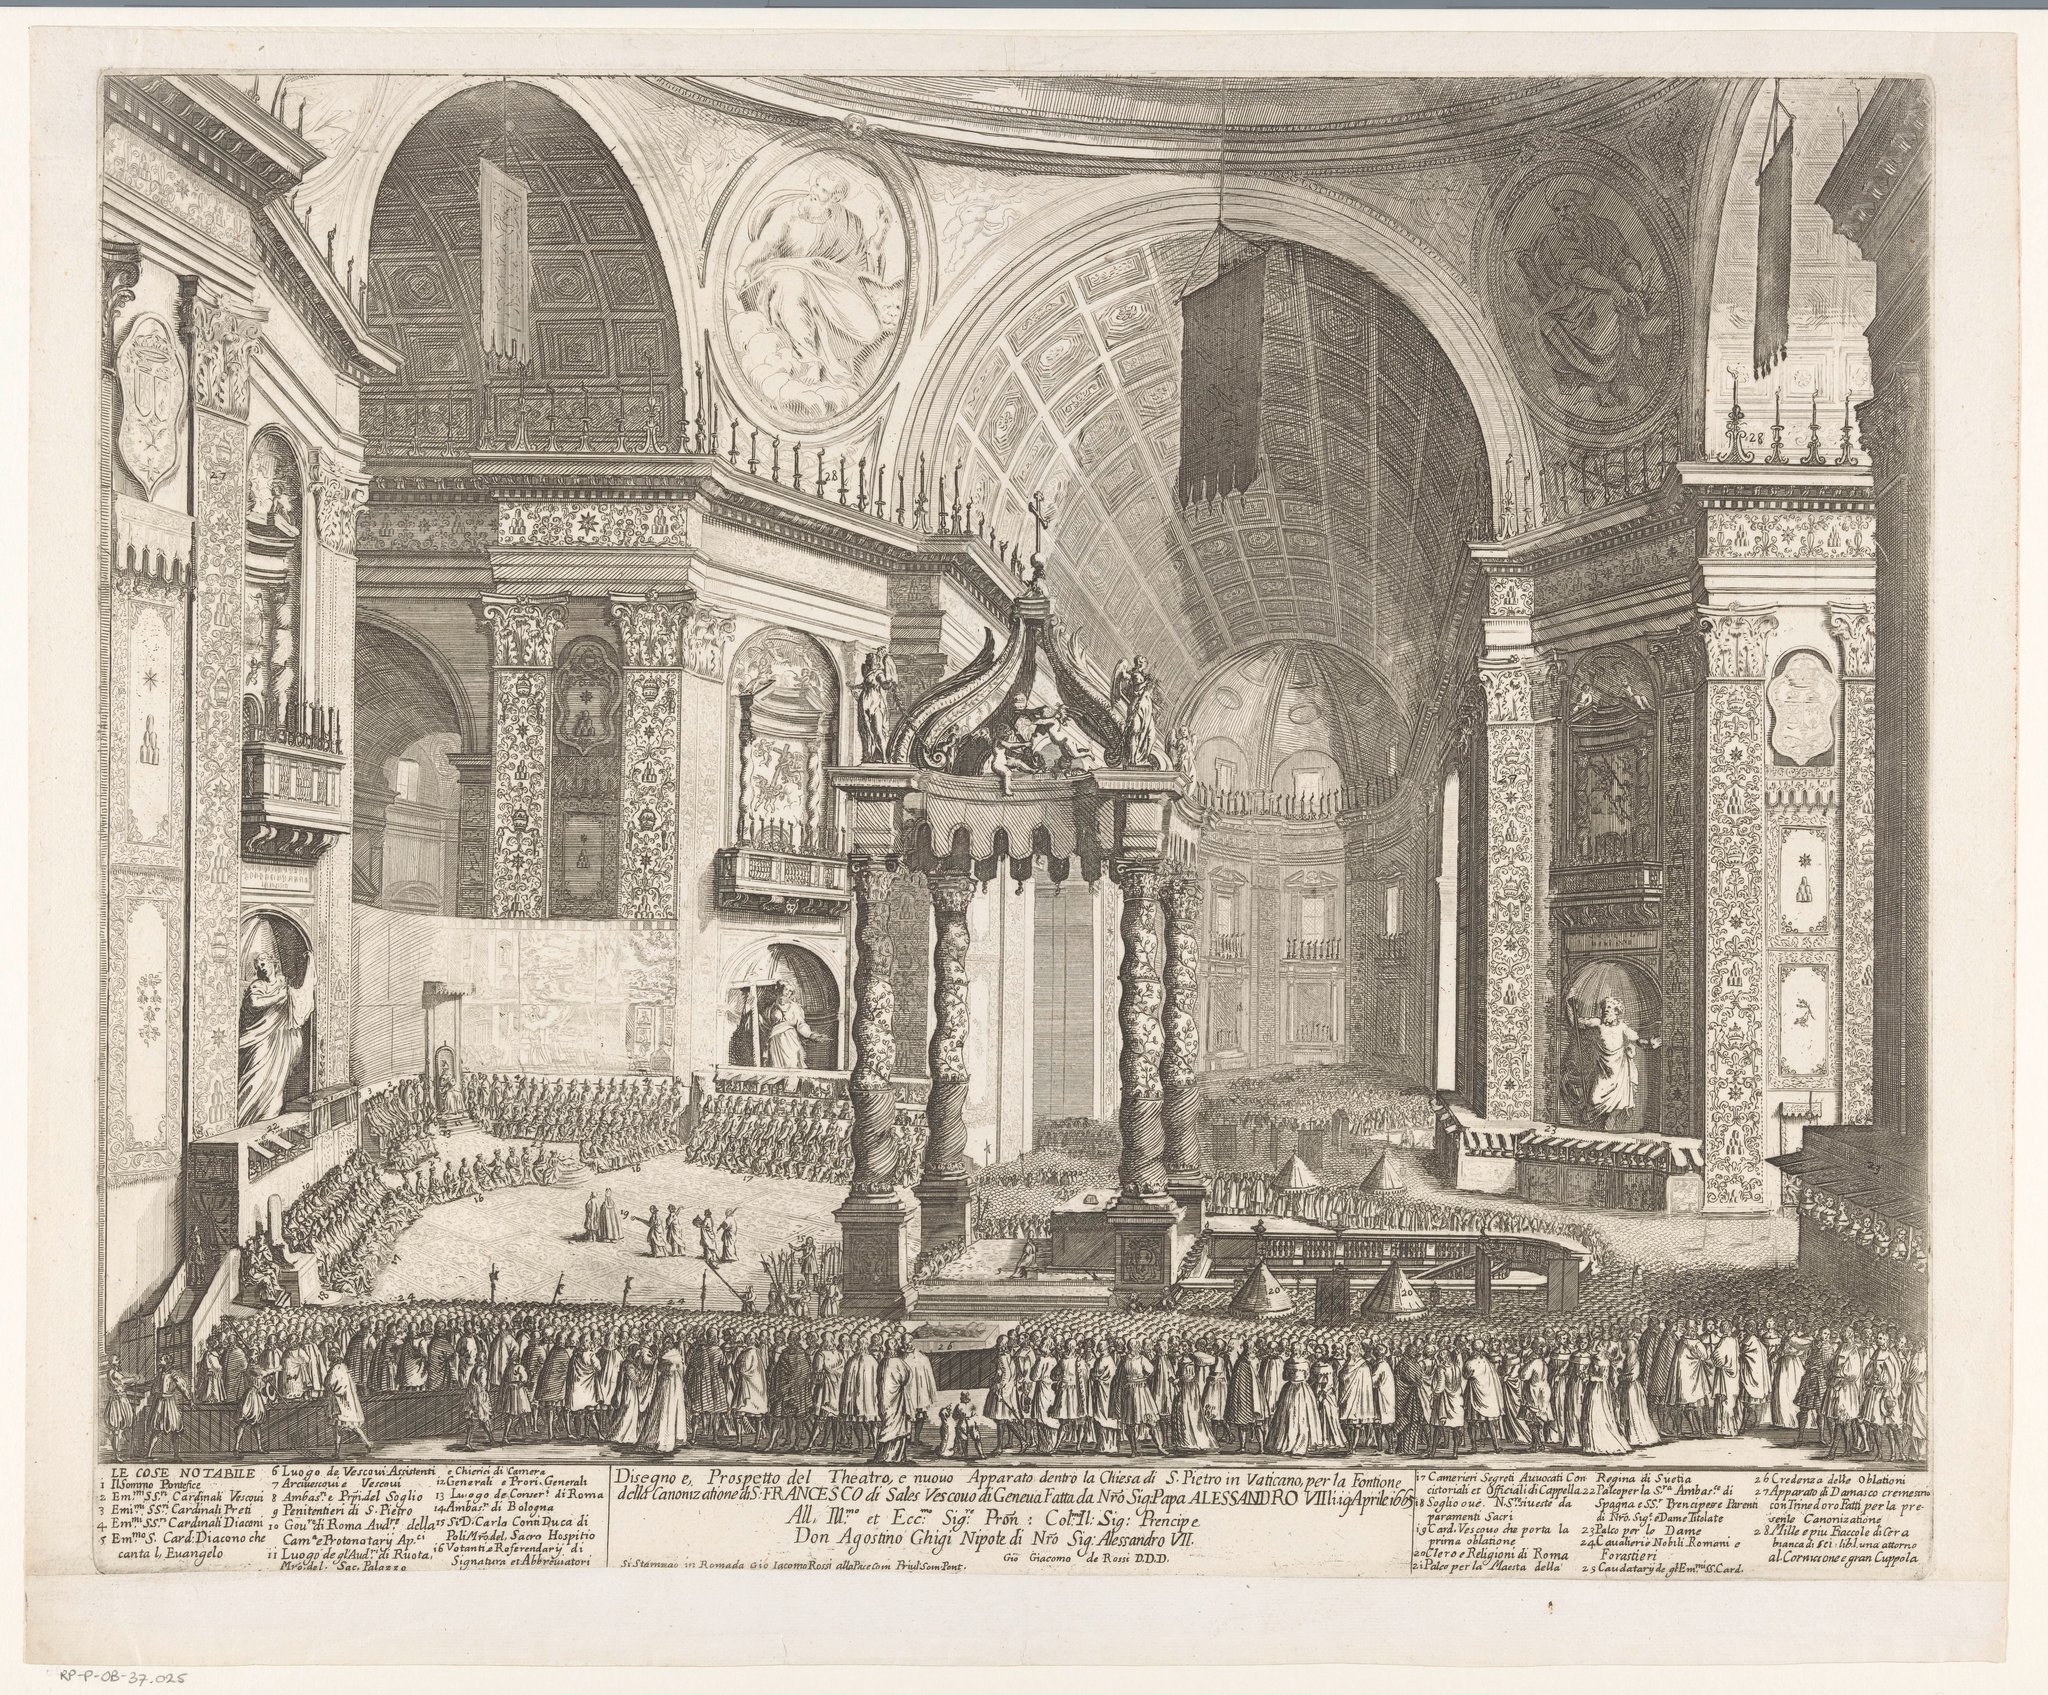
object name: print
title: Disegno e, Prospetto del Theatro, e nuovo Apparato dentro la Chiesa di S. Pietro in Vaticana, per la Fontione della Canonizatione di S. Francesco di Sales Vescovo di Geneu (...)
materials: paper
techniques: etching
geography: italy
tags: the bishop of geneva and doctor of the church, francis of sales; possible attributes: heart entwined with thorns, interior of church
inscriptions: collector's mark: Lugt 2228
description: De heiligverklaring van Franciscus van Sales op 19 april 1665 in de Sint-Pietersbasiliek in het Vaticaan. Een verklarende lijst met nummers, titel en opdracht in het Italiaans in ondermarge.